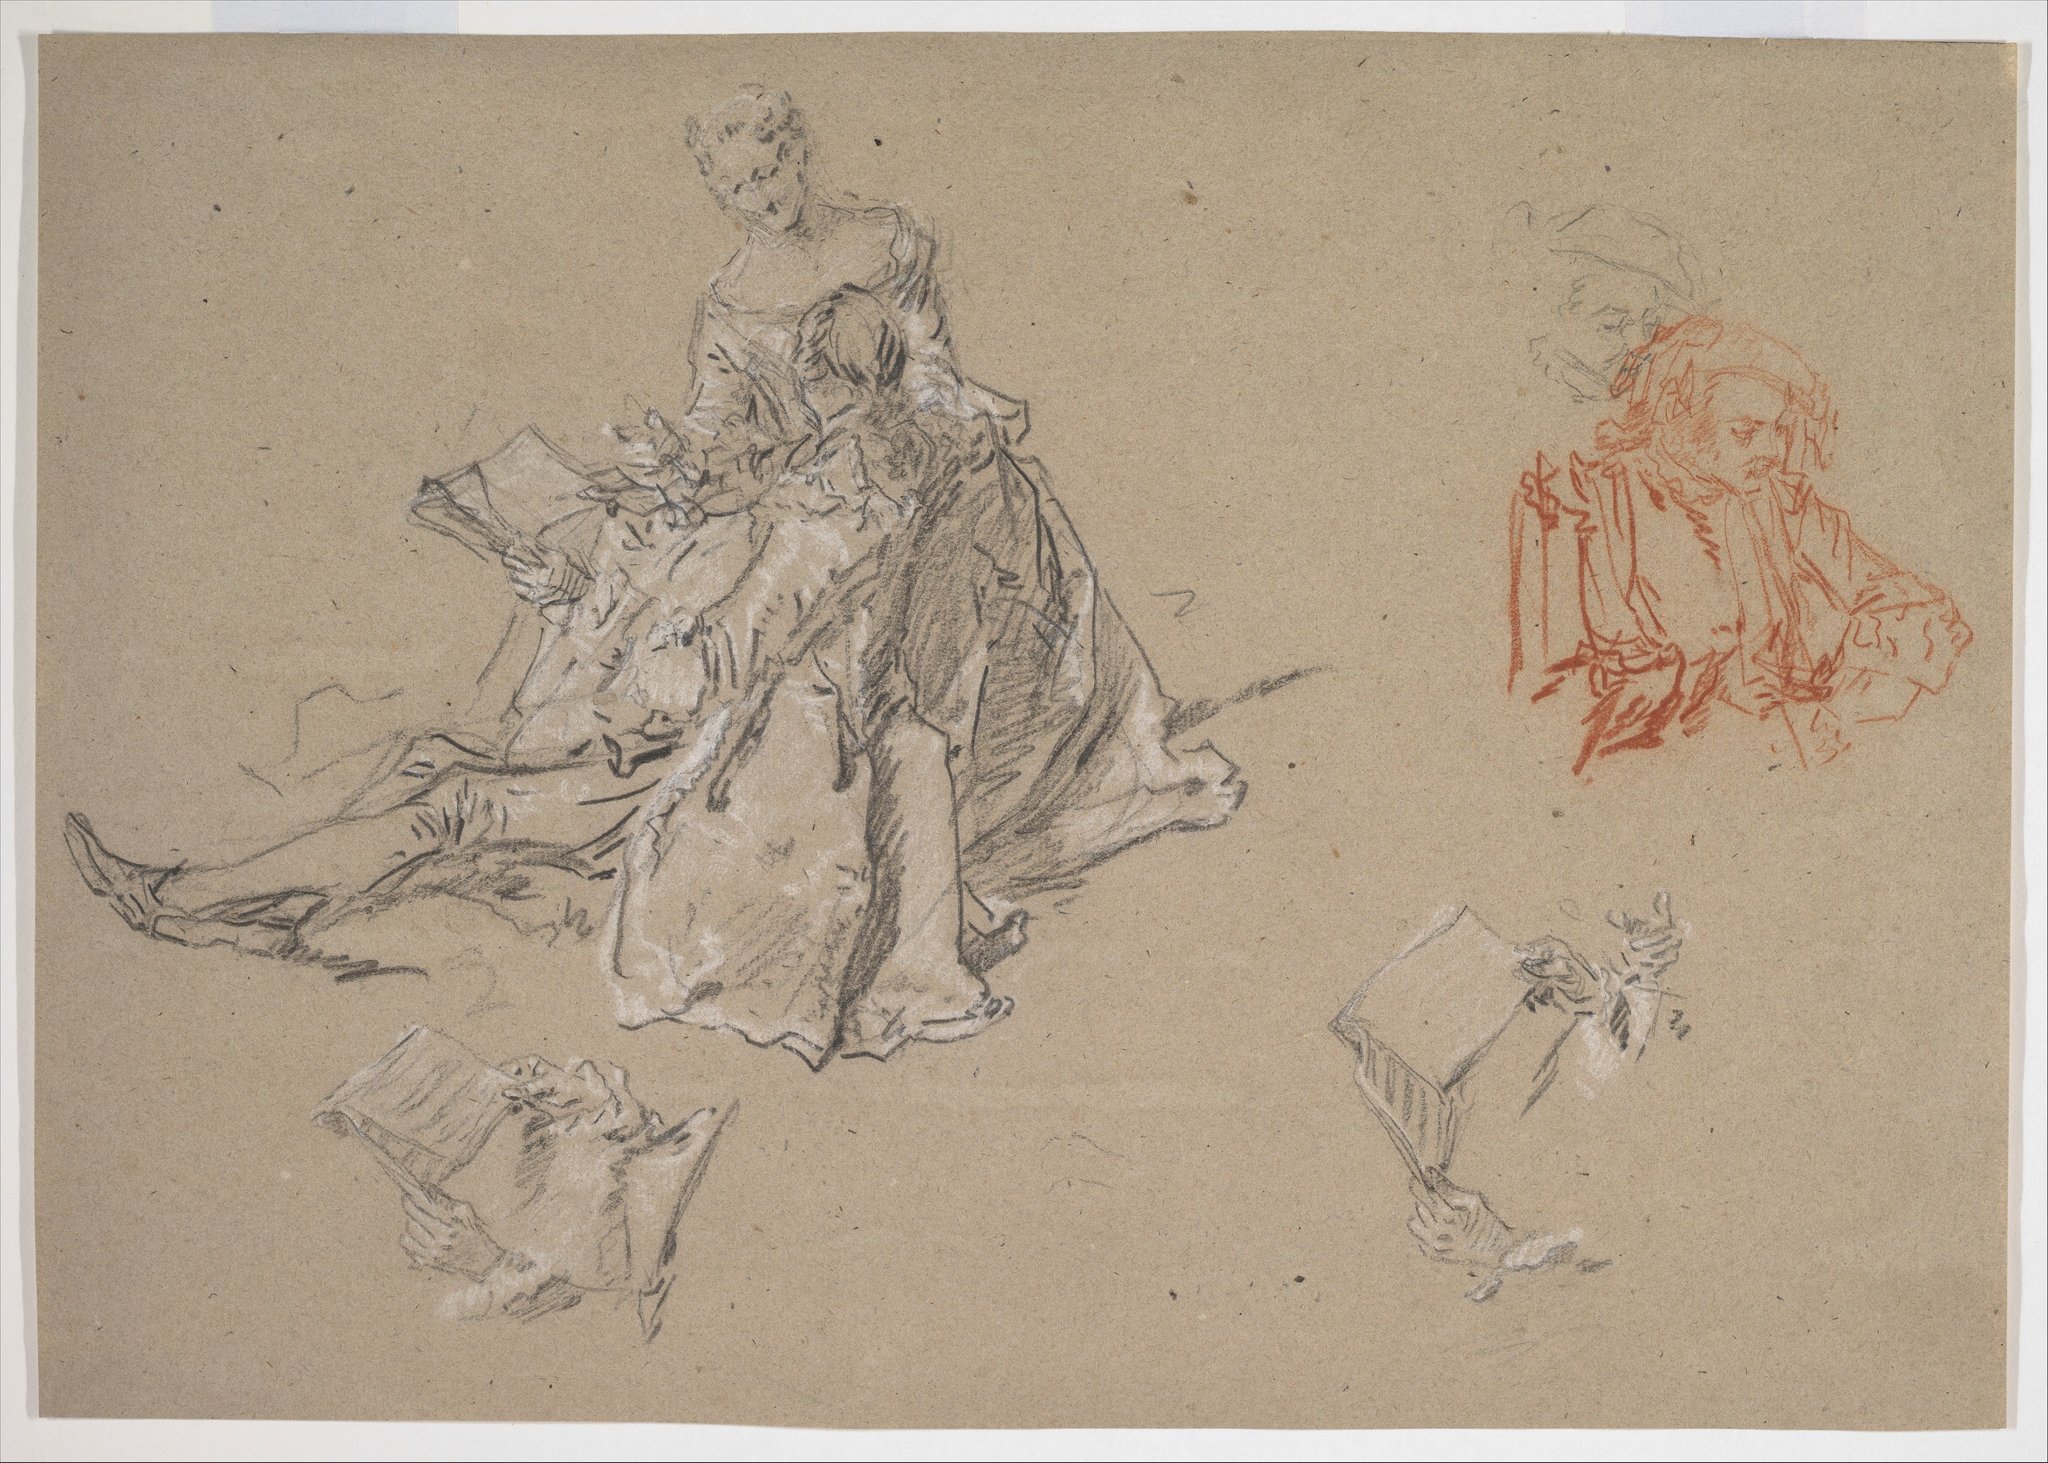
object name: drawing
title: Studies of a Couple Seated on the Ground, Looking at a Songbook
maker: nicolas lancret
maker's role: artist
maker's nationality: french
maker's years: 1690-1743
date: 1740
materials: chalk, paper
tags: books,couples,men,women